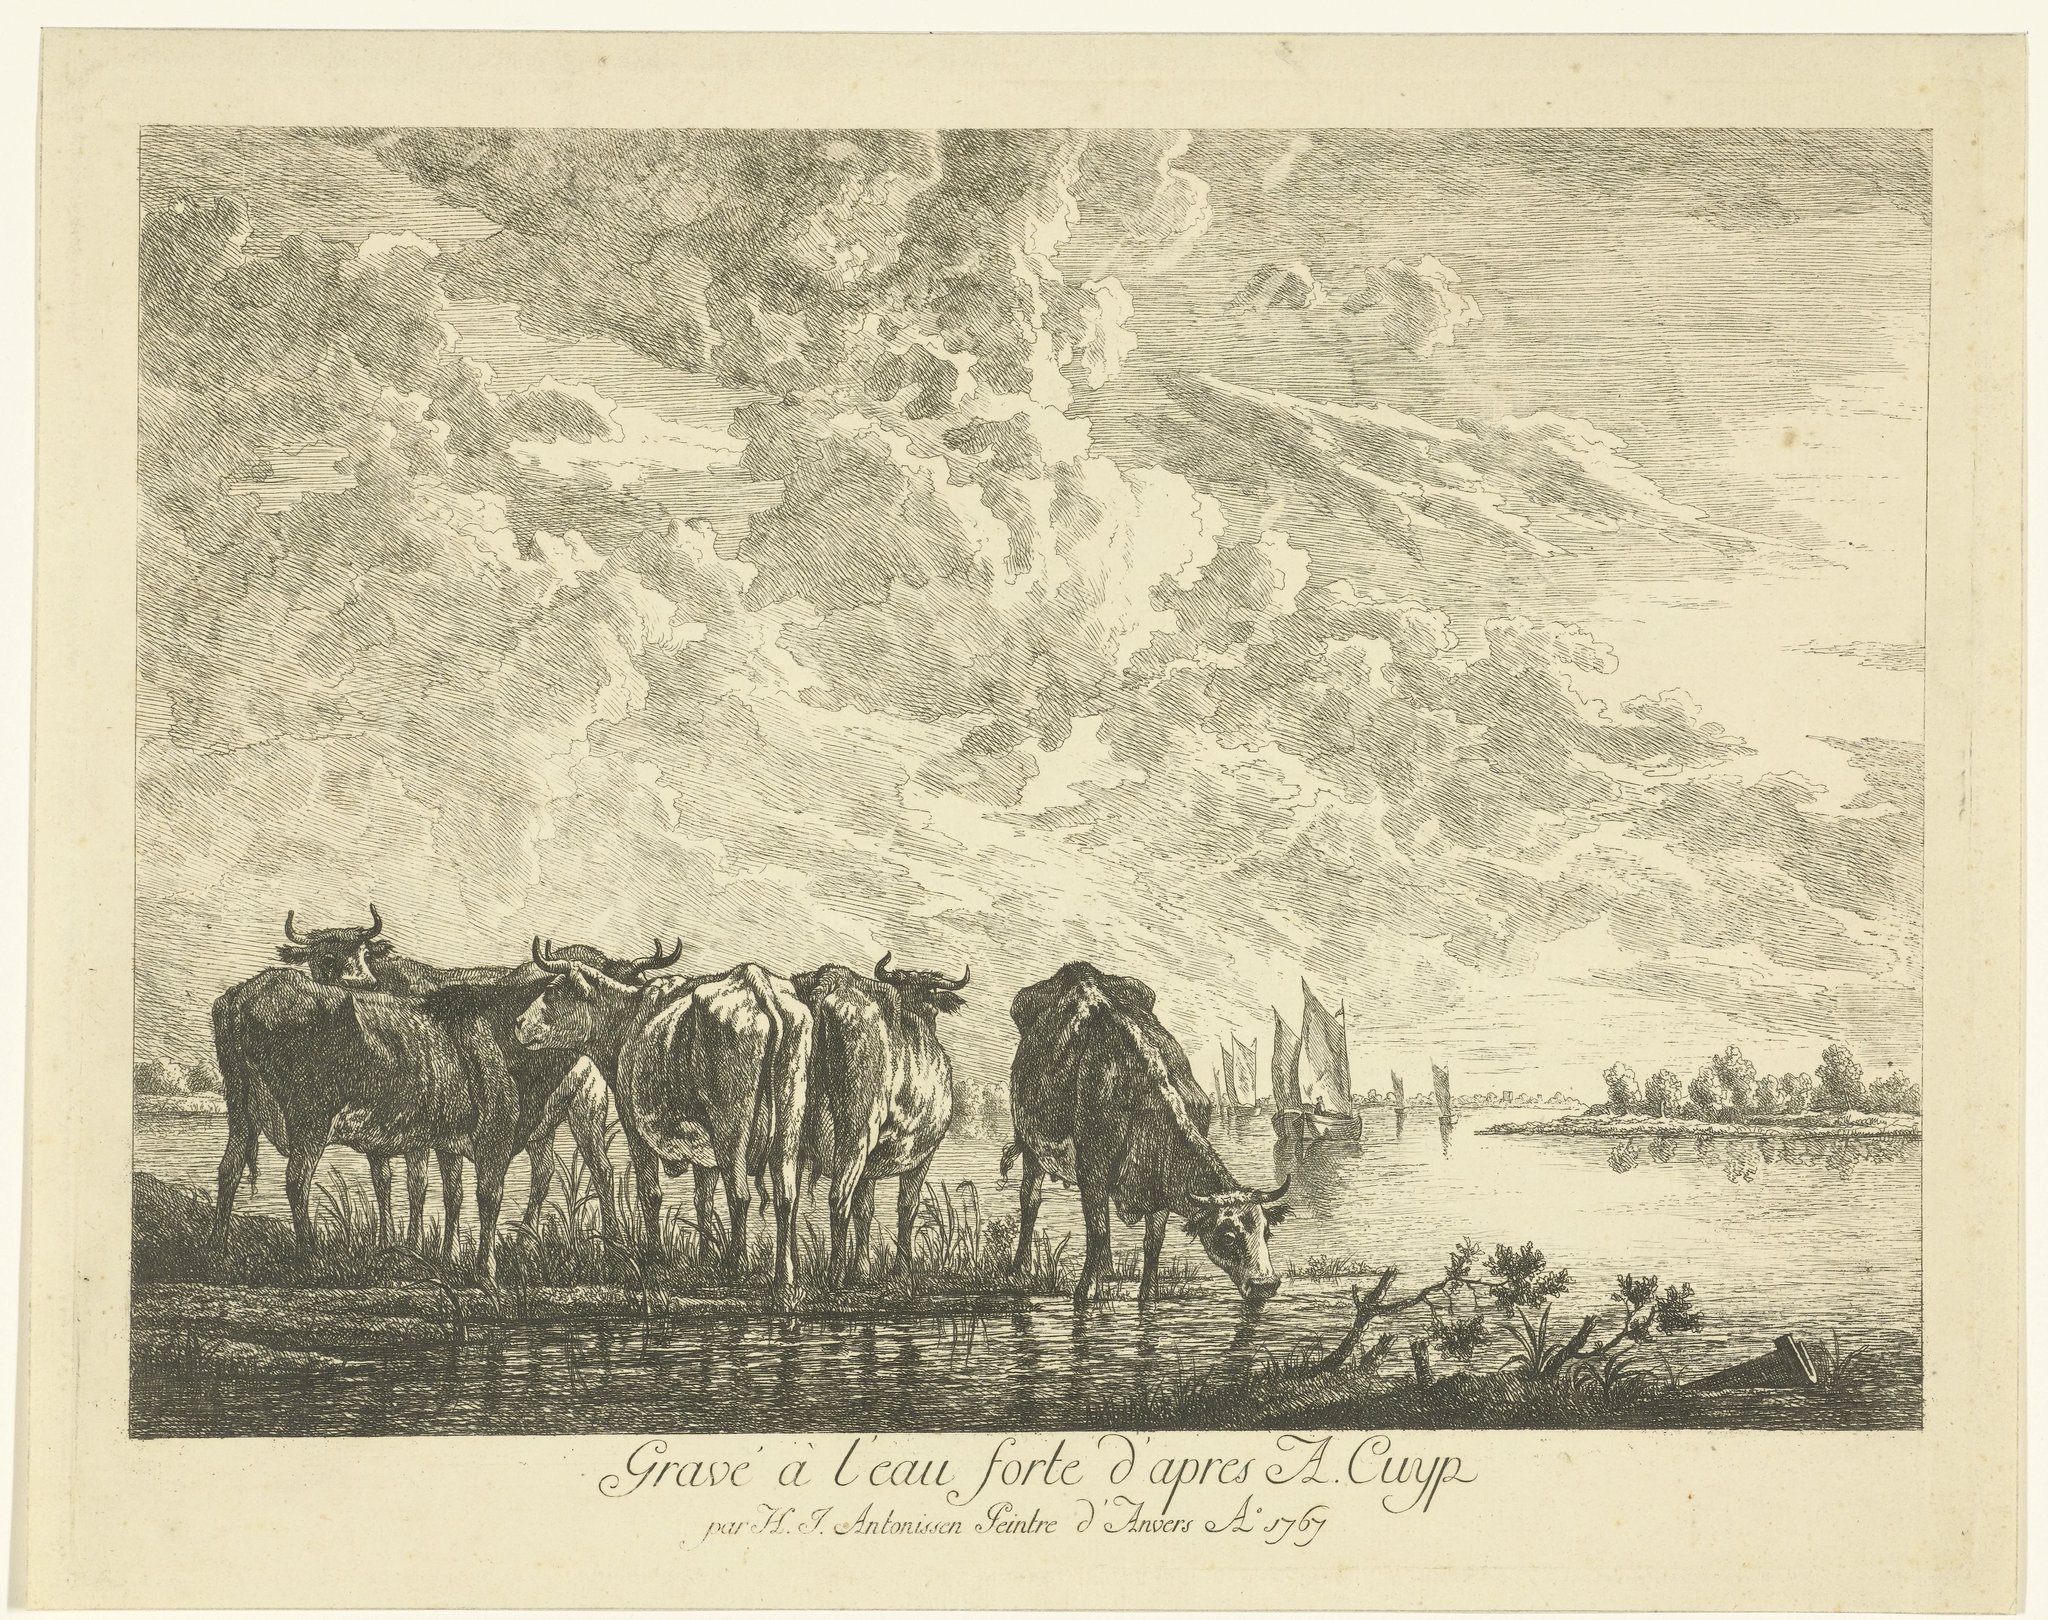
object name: print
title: Landschap met vijf koeien bij een rivier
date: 1767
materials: paper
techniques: etching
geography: netherlands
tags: landscapes with waters, waterscapes, seascapes (in the temperate zone), bovine cattle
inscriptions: inscription, collector's mark: Lugt 2228